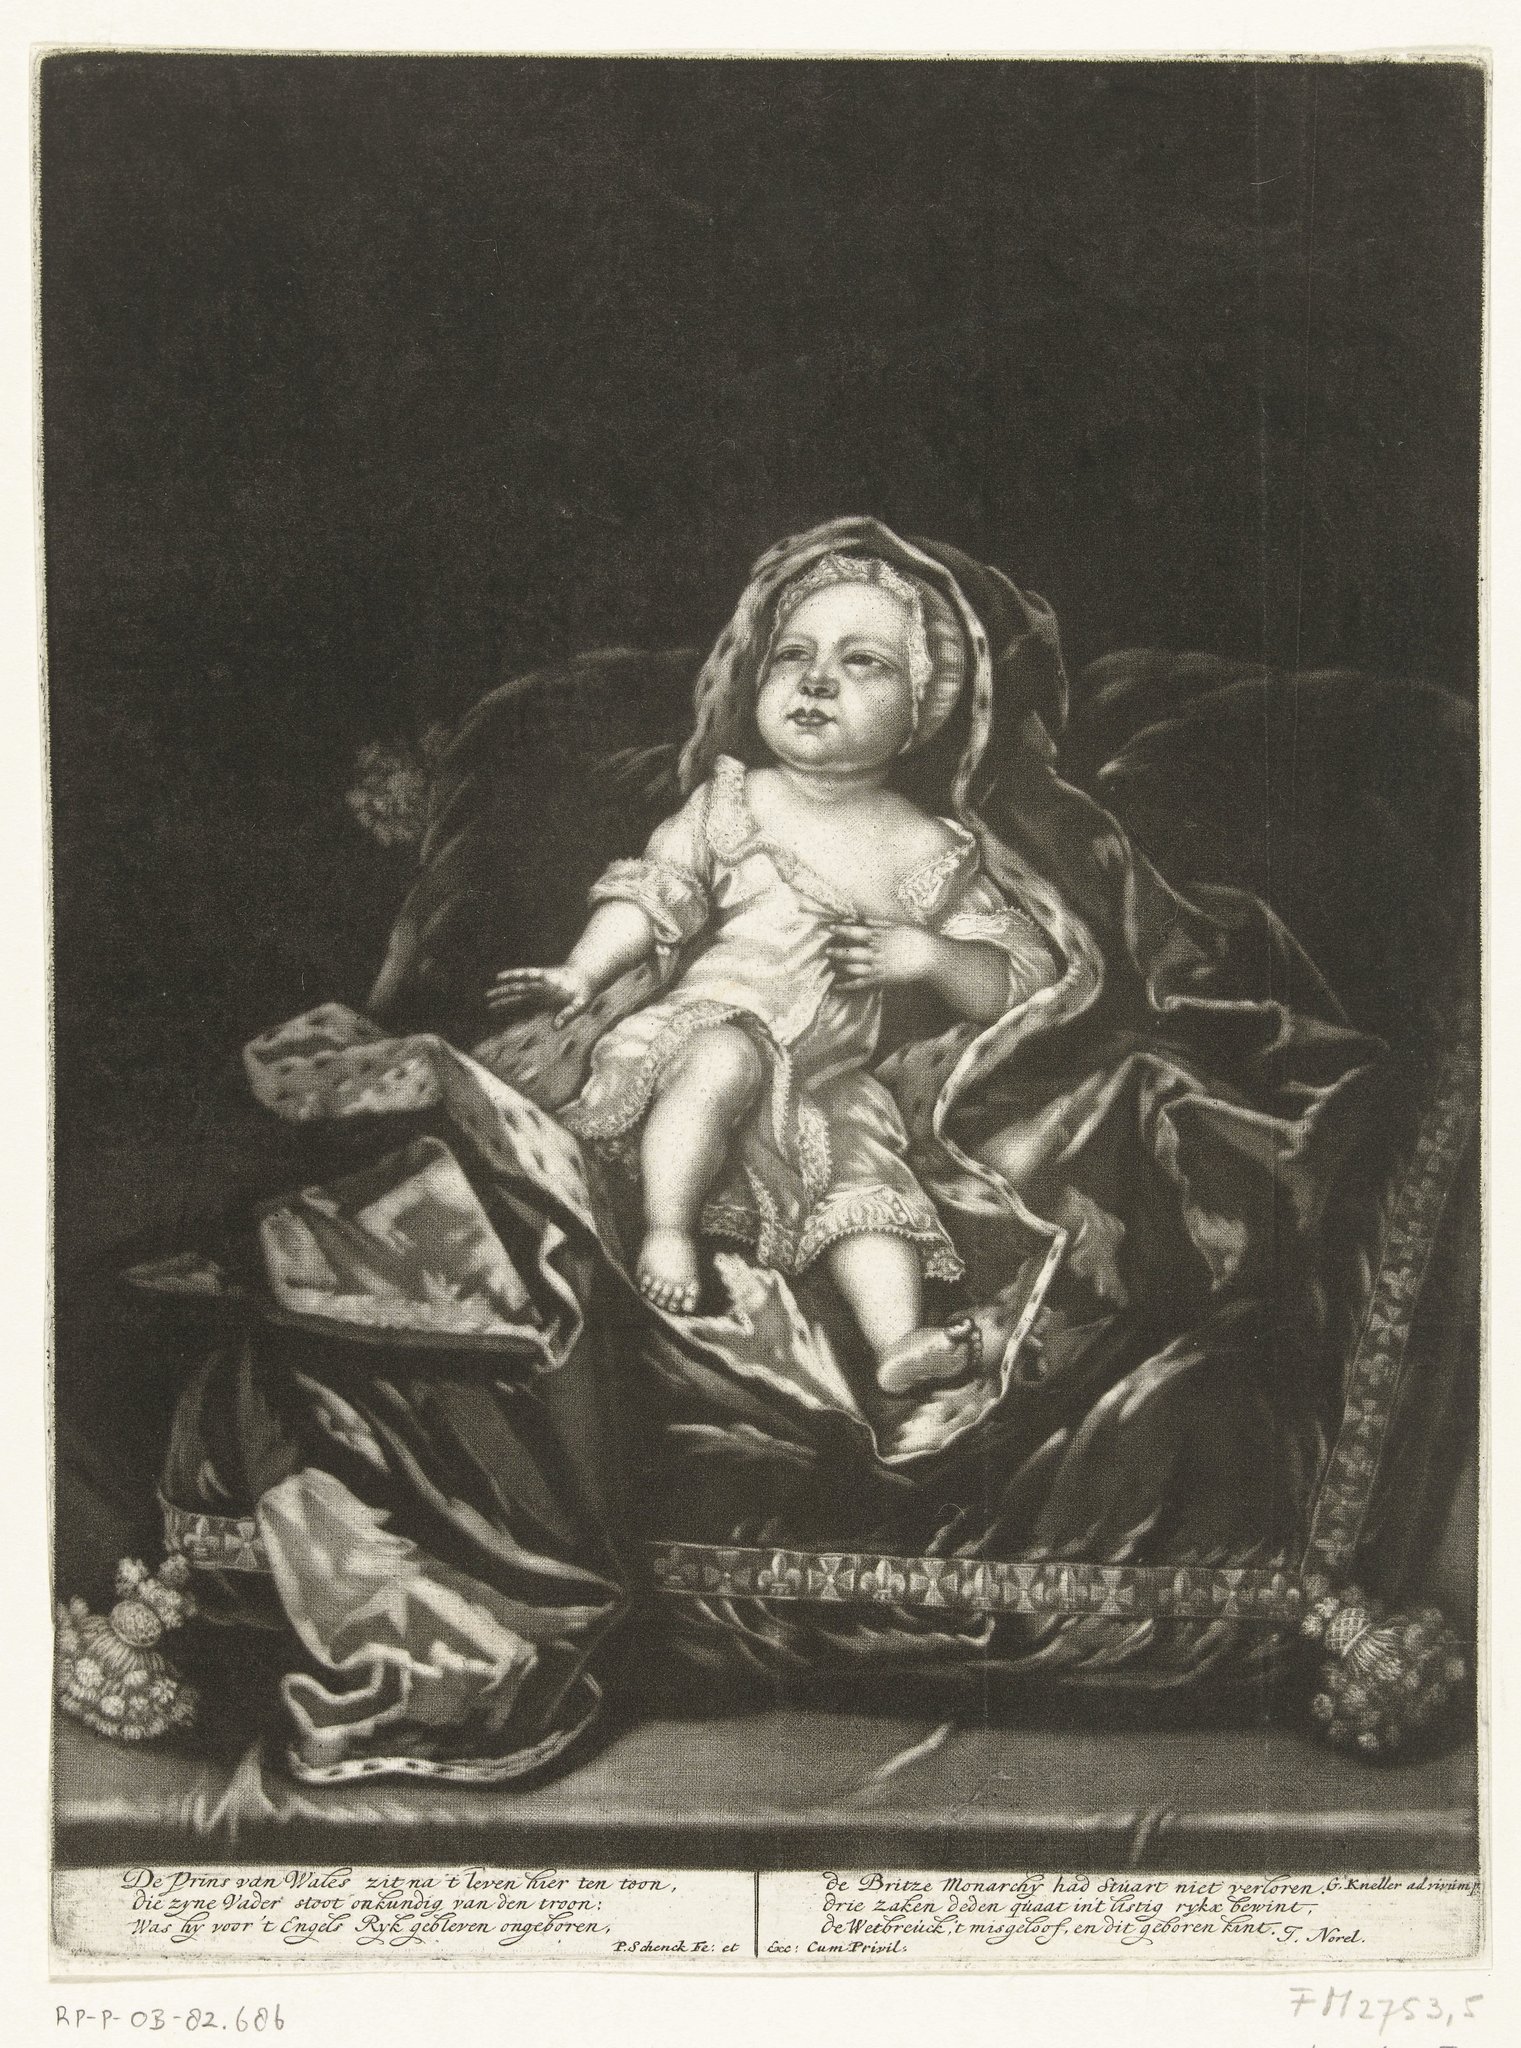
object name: cartoon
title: Jacobus Frans Eduard, prins van Wales, 1688-1689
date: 1688-1689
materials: paper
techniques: mezzotint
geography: northern netherlands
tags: london, infant, baby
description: Het kind Jacobus Frans Eduard, prins van Wales, zittend op een fluwelen kussen. In het onderschrift van 2 verzen van 3 regels wordt dit kind genoemd als één van de drie problemen van Groot-Brittannië.